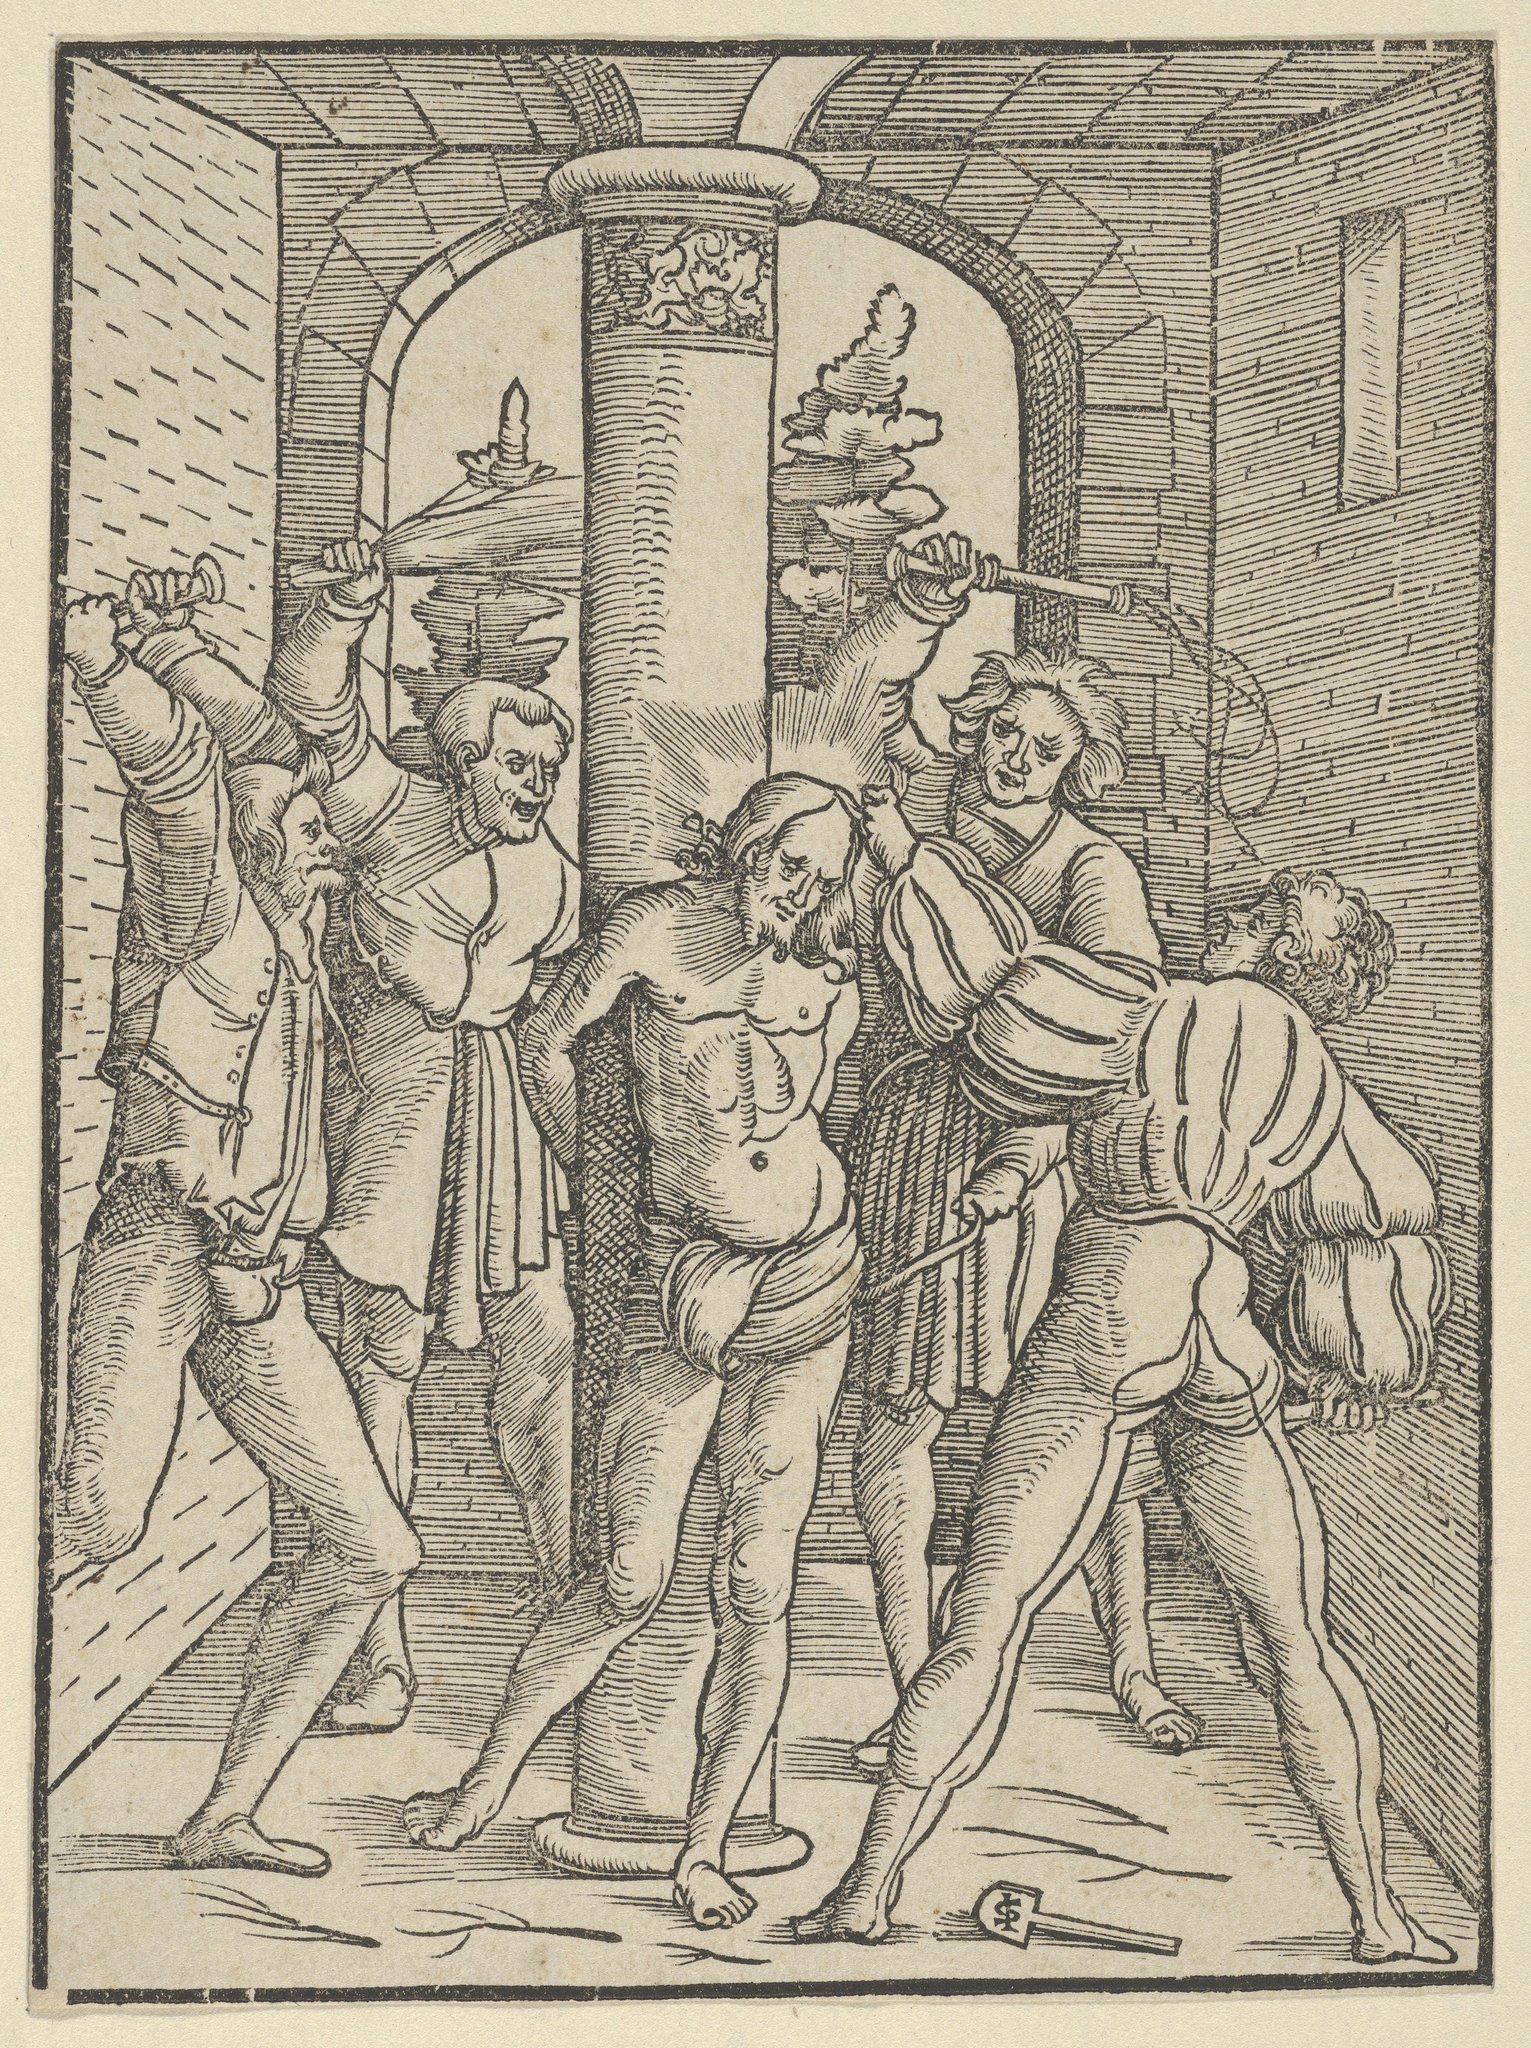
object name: print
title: Christ Scourged, from "The Doctrine, Life, and Passion of Jesus Christ"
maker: hans schäufelein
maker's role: artist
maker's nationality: german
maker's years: 1480-1540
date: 1537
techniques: woodcut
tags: men,christ